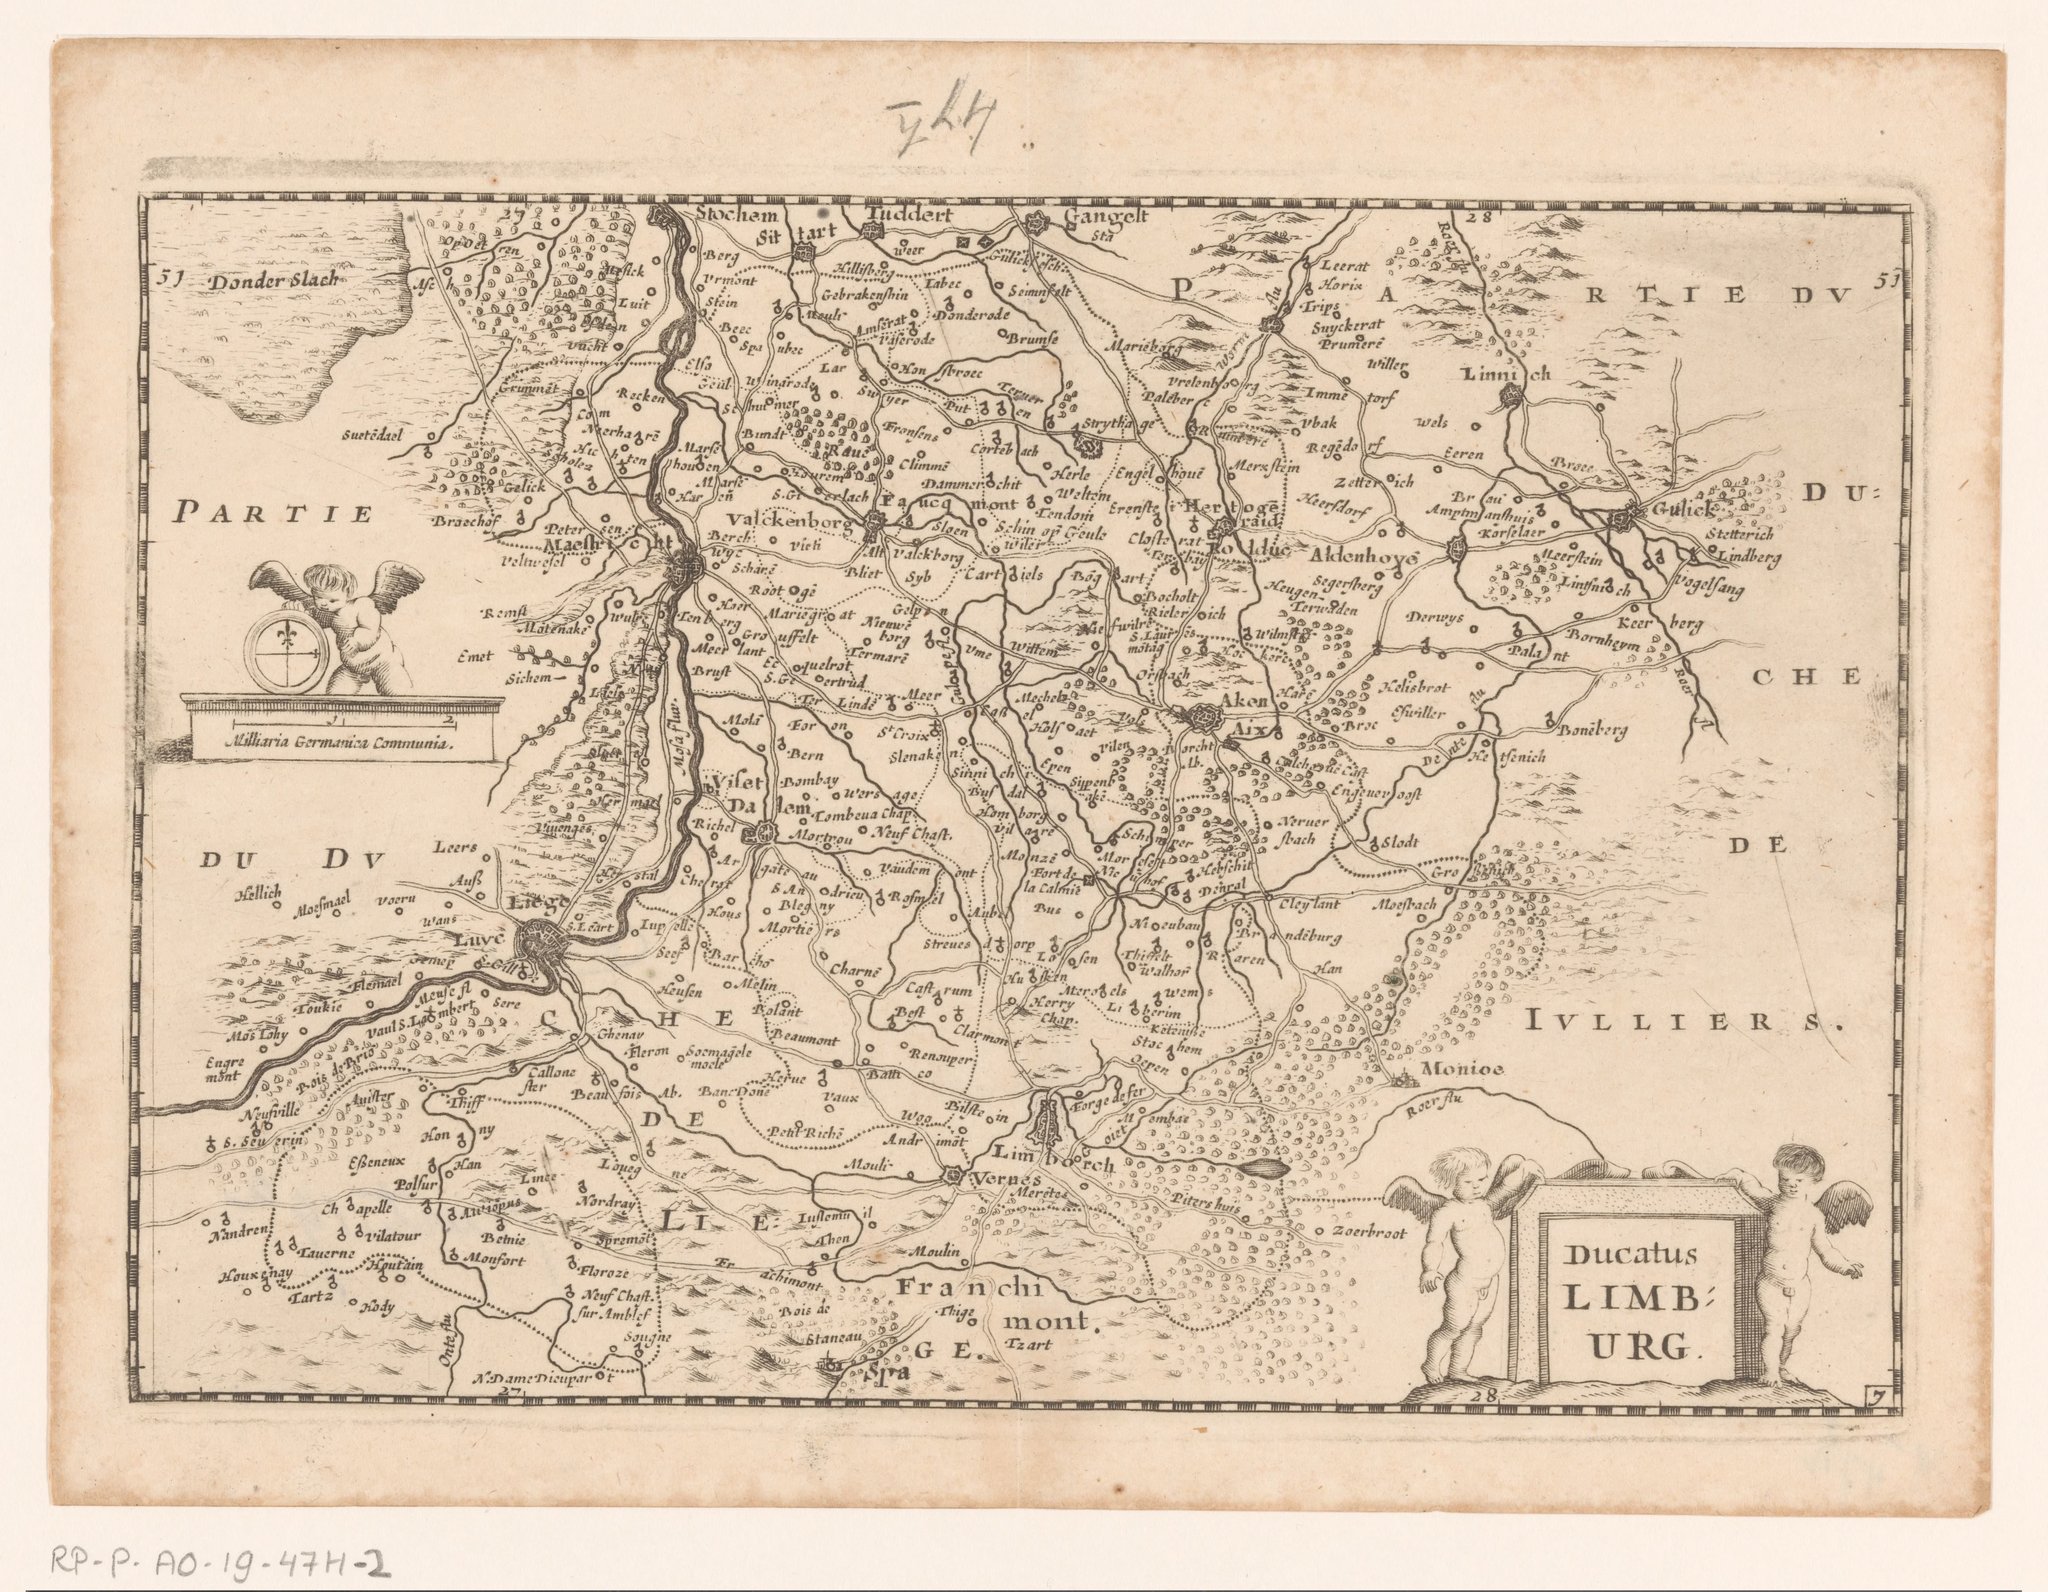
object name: map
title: Ducatus Limburg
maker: Anonymous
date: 1635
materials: paper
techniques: engraving, etching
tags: maps of separate countries or regions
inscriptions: collector's mark: Lugt 2228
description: Deze staat van prent ook gebruikt in: De vyerighe colom klaer vertoonende in vyftich onderscheydene curieuse caarten de XVII. Nederlantsche Provincien (…). Amsterdam: Jacob Aertsz Colom (I), s.a. [ca. 1660]. En in latere uitgaven met de platen van deze publicatie, uitgegeven door Pieter van Alphen (1691) en Pieter van der Slaart (1696). Eerdere staat van prent (zonder '7' rechtsonder) ook gebruikt in eerdere drukken van deze publicatie.